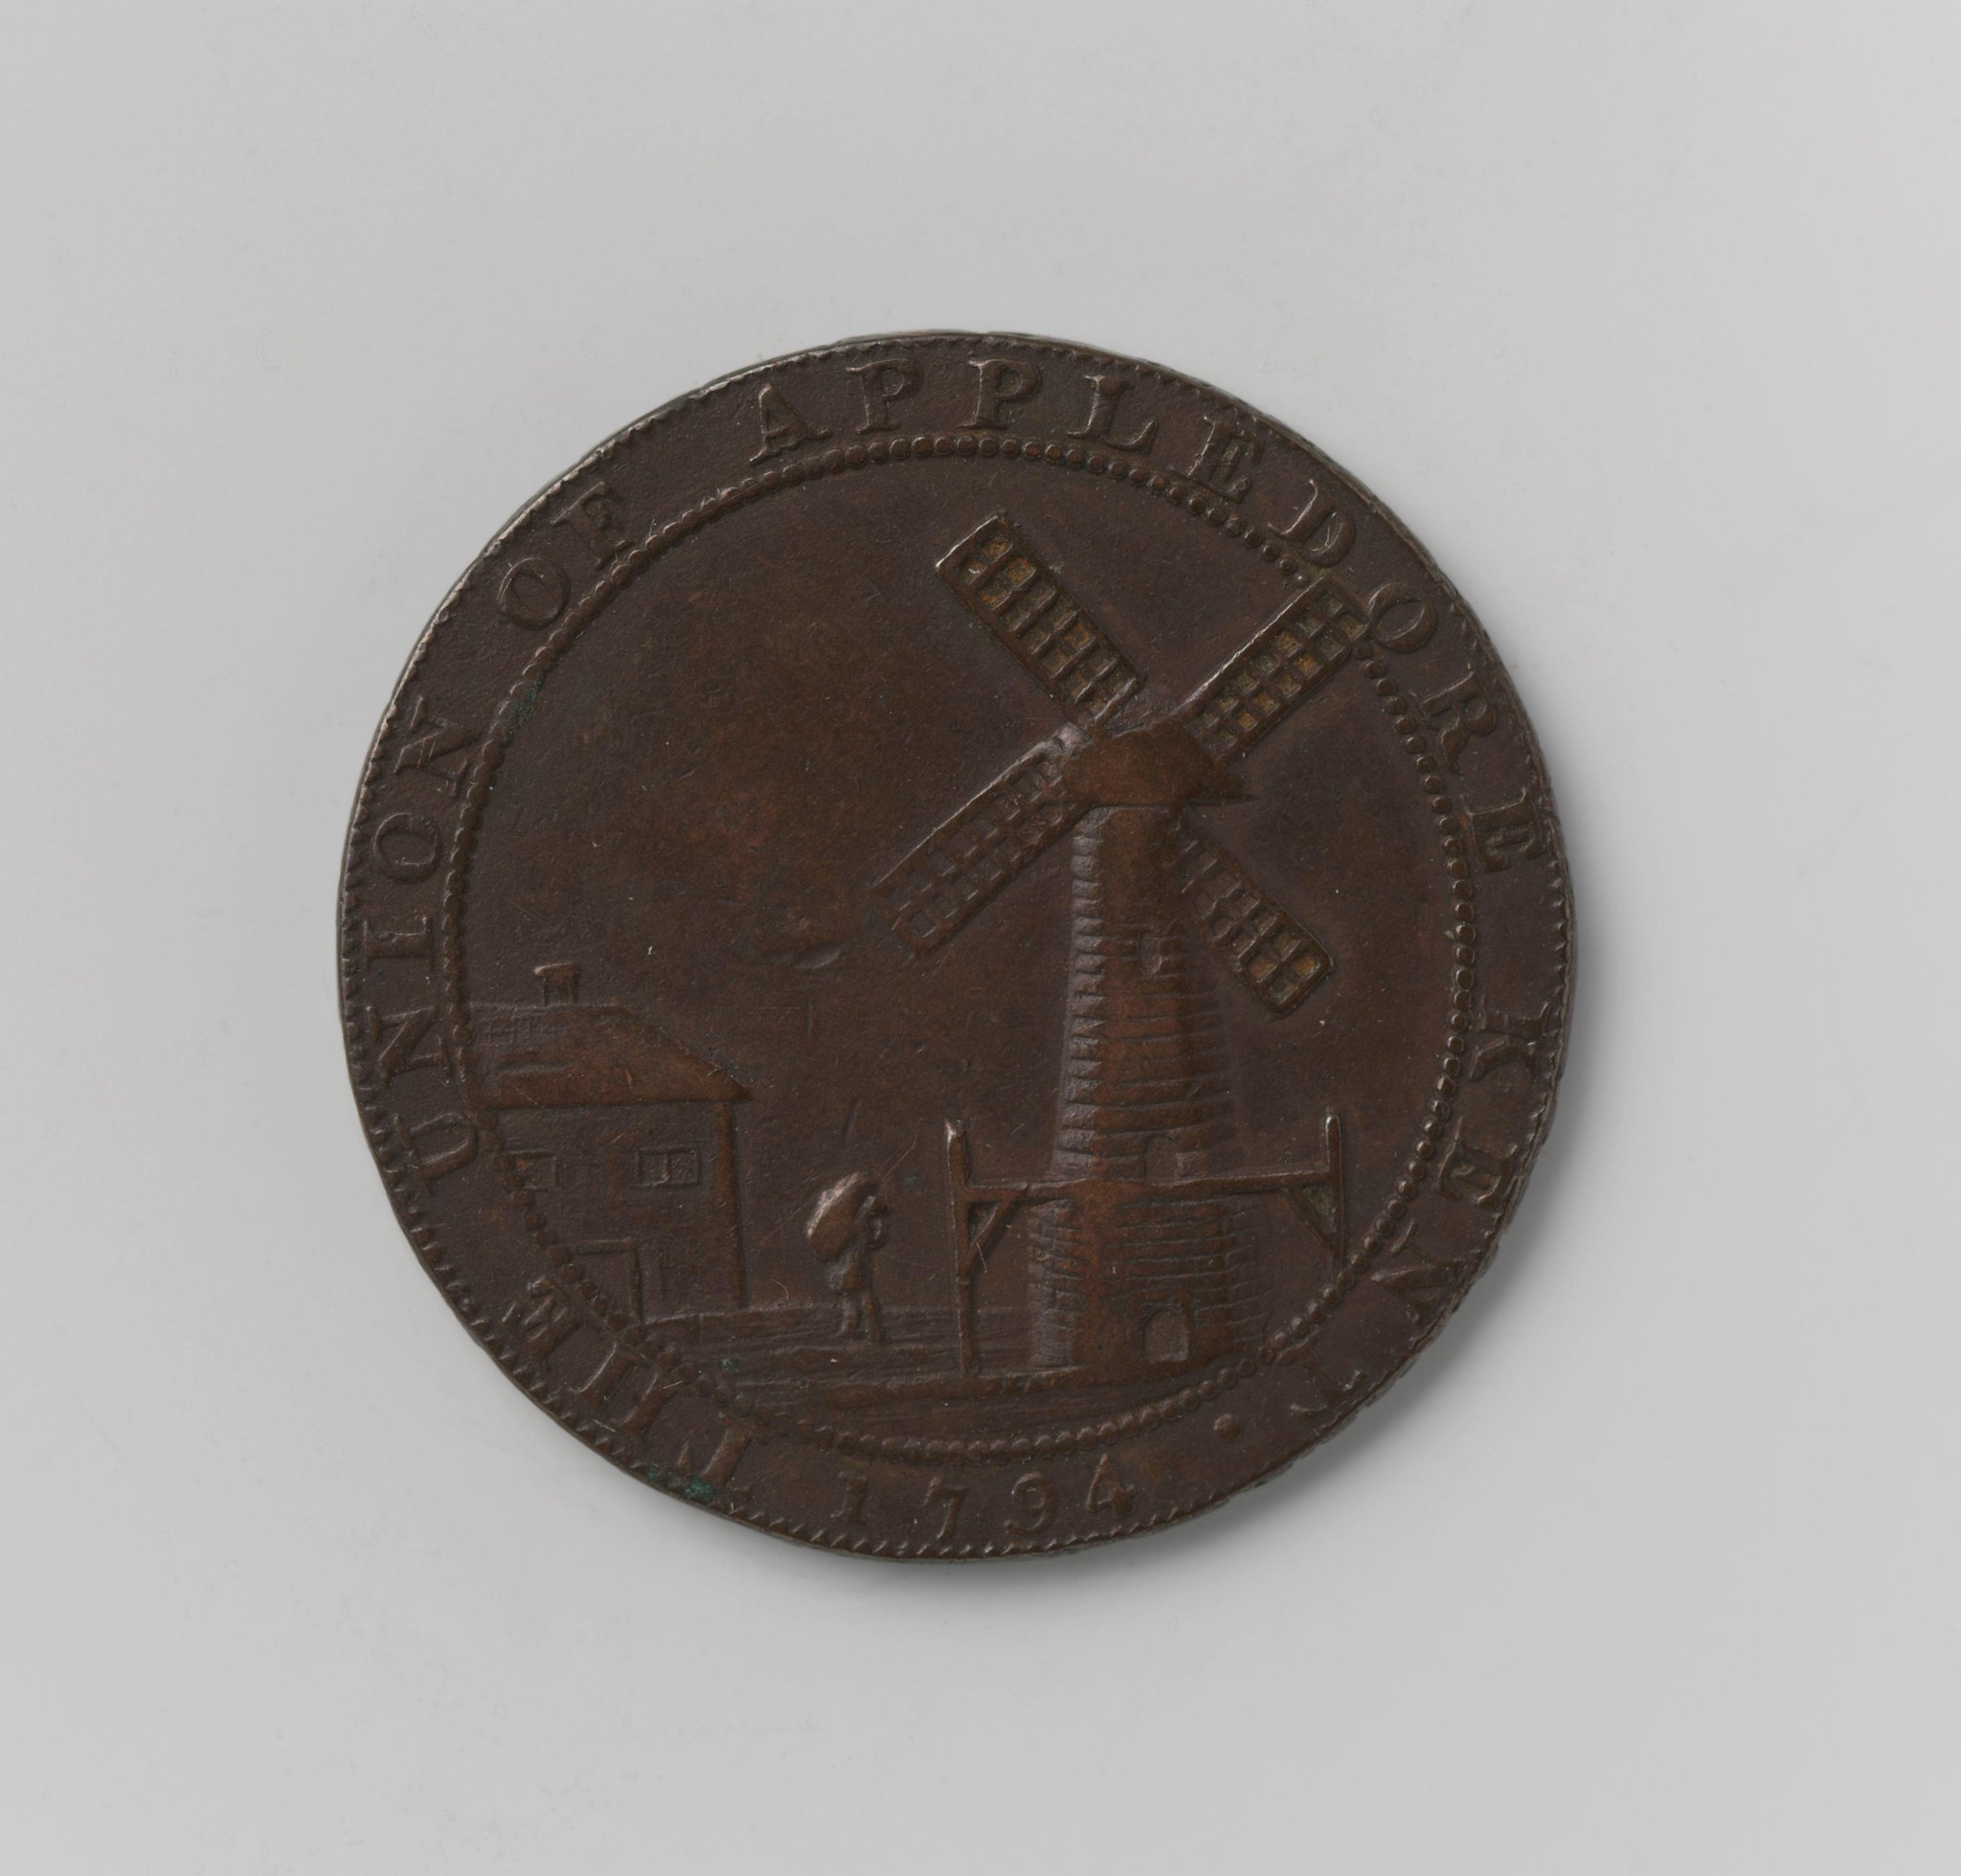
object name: monetary token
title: Token voor een penny uit Appledore, Engeland, 1794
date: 1794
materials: copper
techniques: striking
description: Koperen particuliere munt. Voorzijde: rechts molen, links huis. Keerzijde: in veld liggende leeuw. Randschrift.